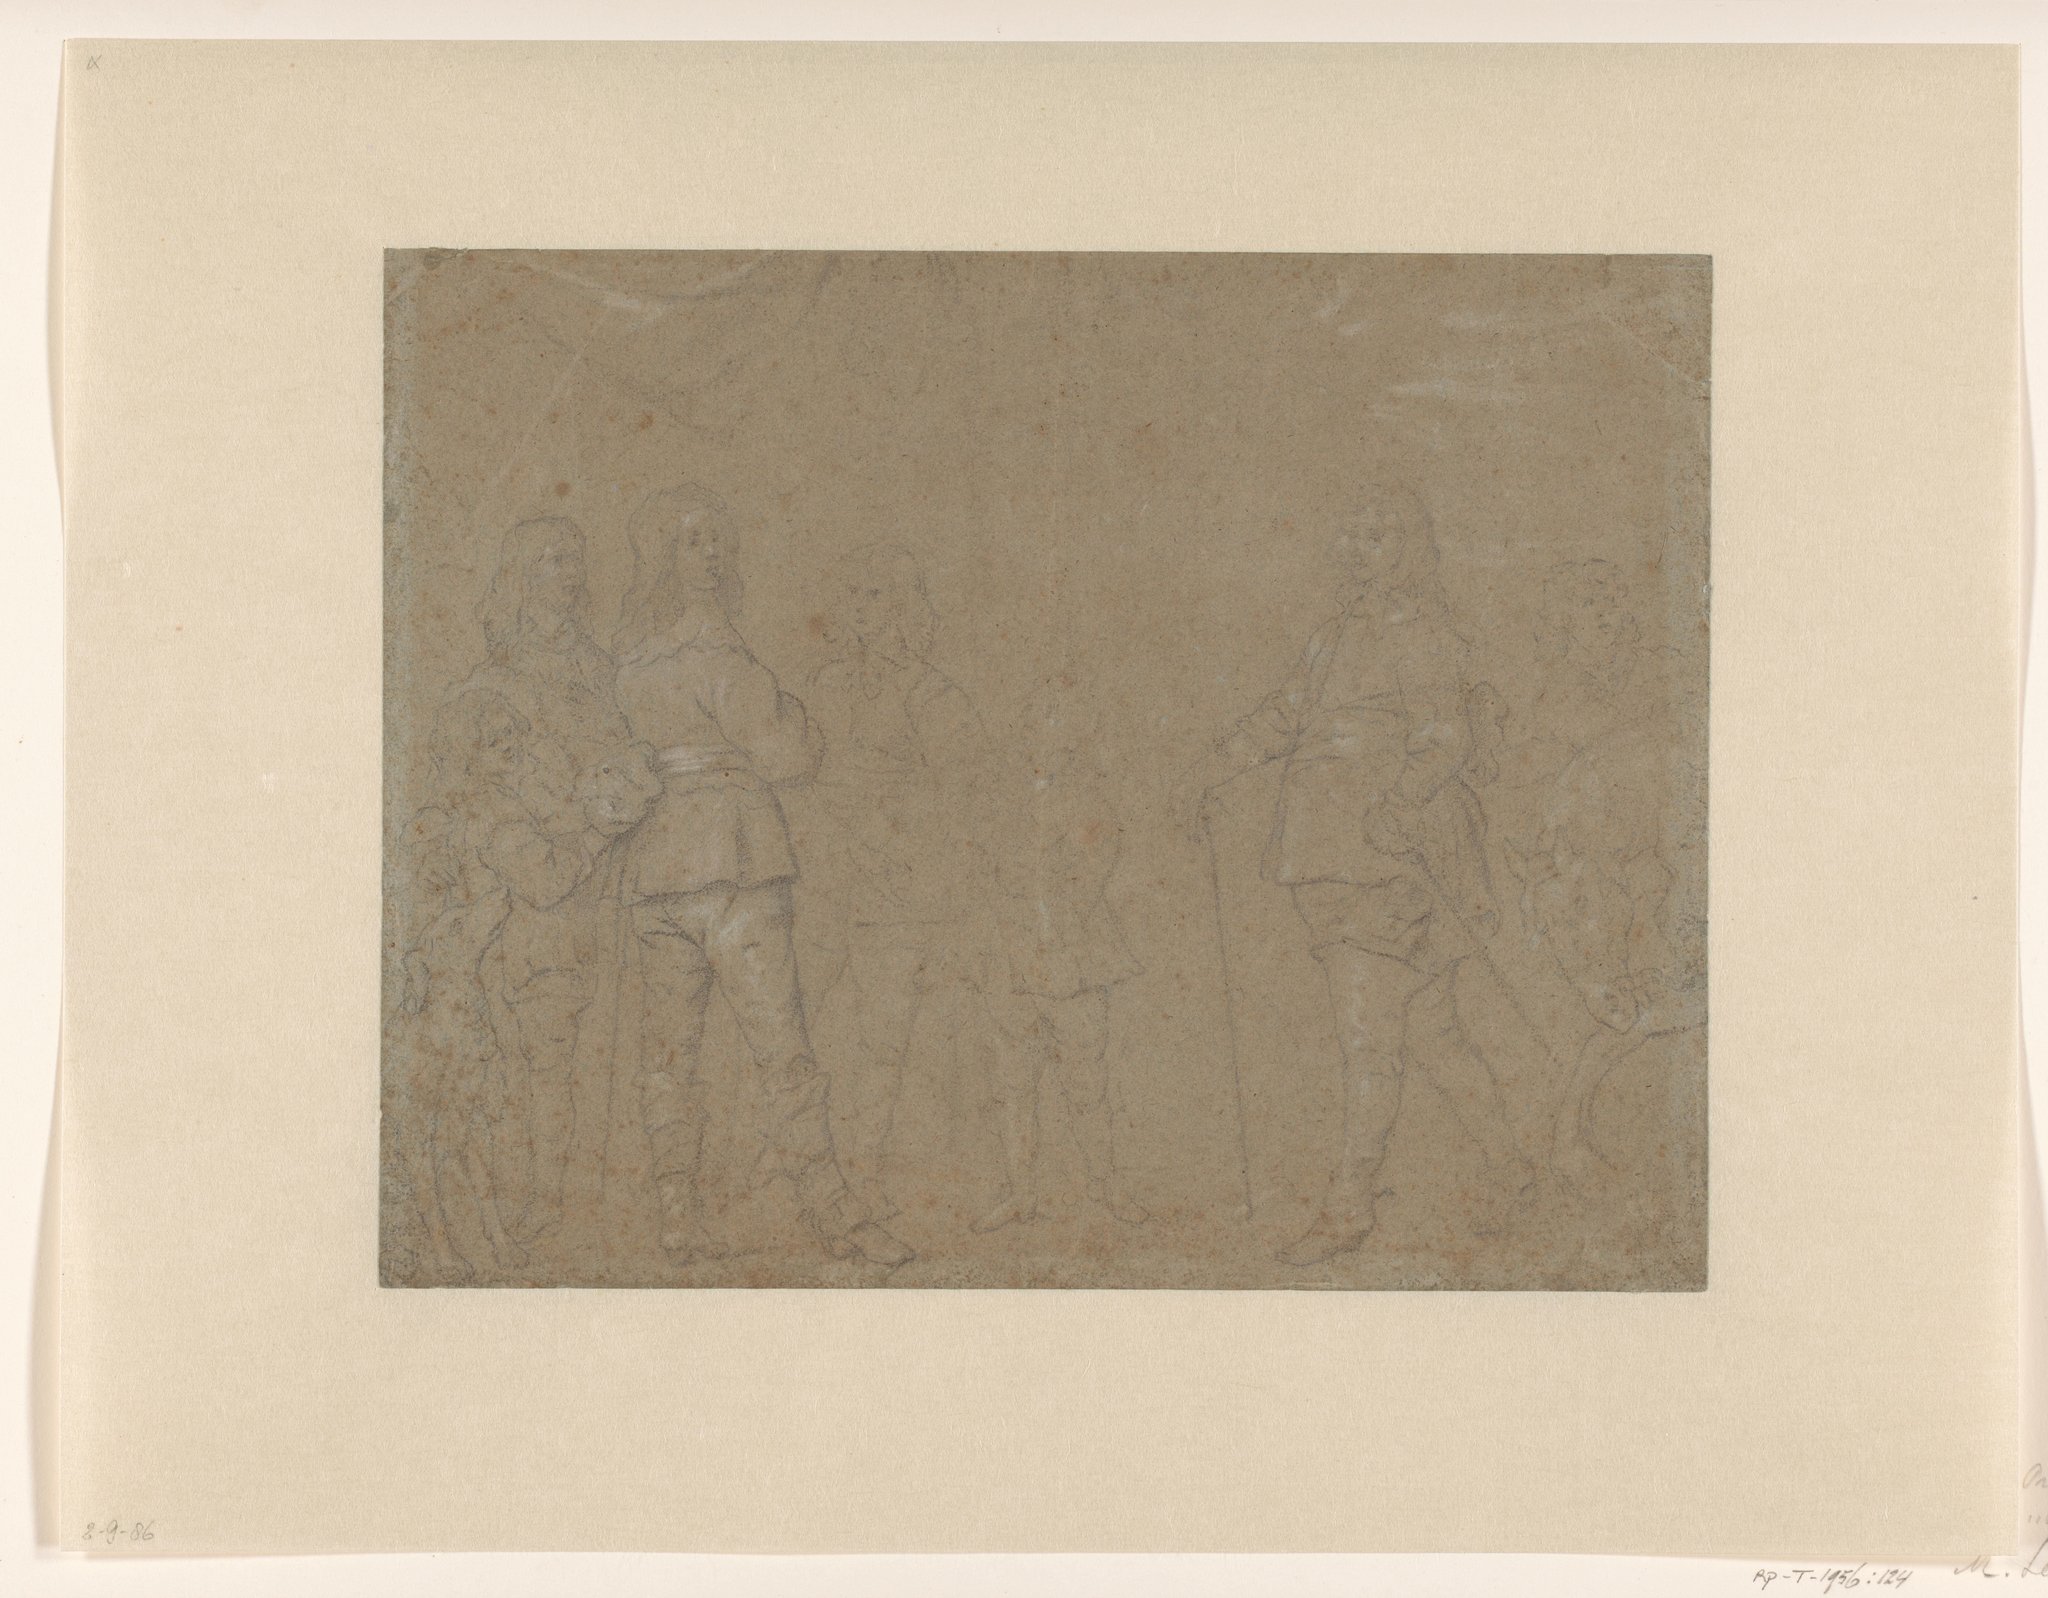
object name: drawing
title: Prinsengroep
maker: martinus lengele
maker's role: draughtsman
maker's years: -1668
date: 1640-1660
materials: chalk, paper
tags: graaf hendrik van nassau-siegen, bergen op zoom, arnhem, hendrik casimir i graaf van nassau-dietz, historical persons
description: Willem Frederik van Nassau-Dietz met page en paard tegenover zijn oudere broer en voorganger Hendrik Casimier I en twee Siegense neven: Hendrik en George Frederik.